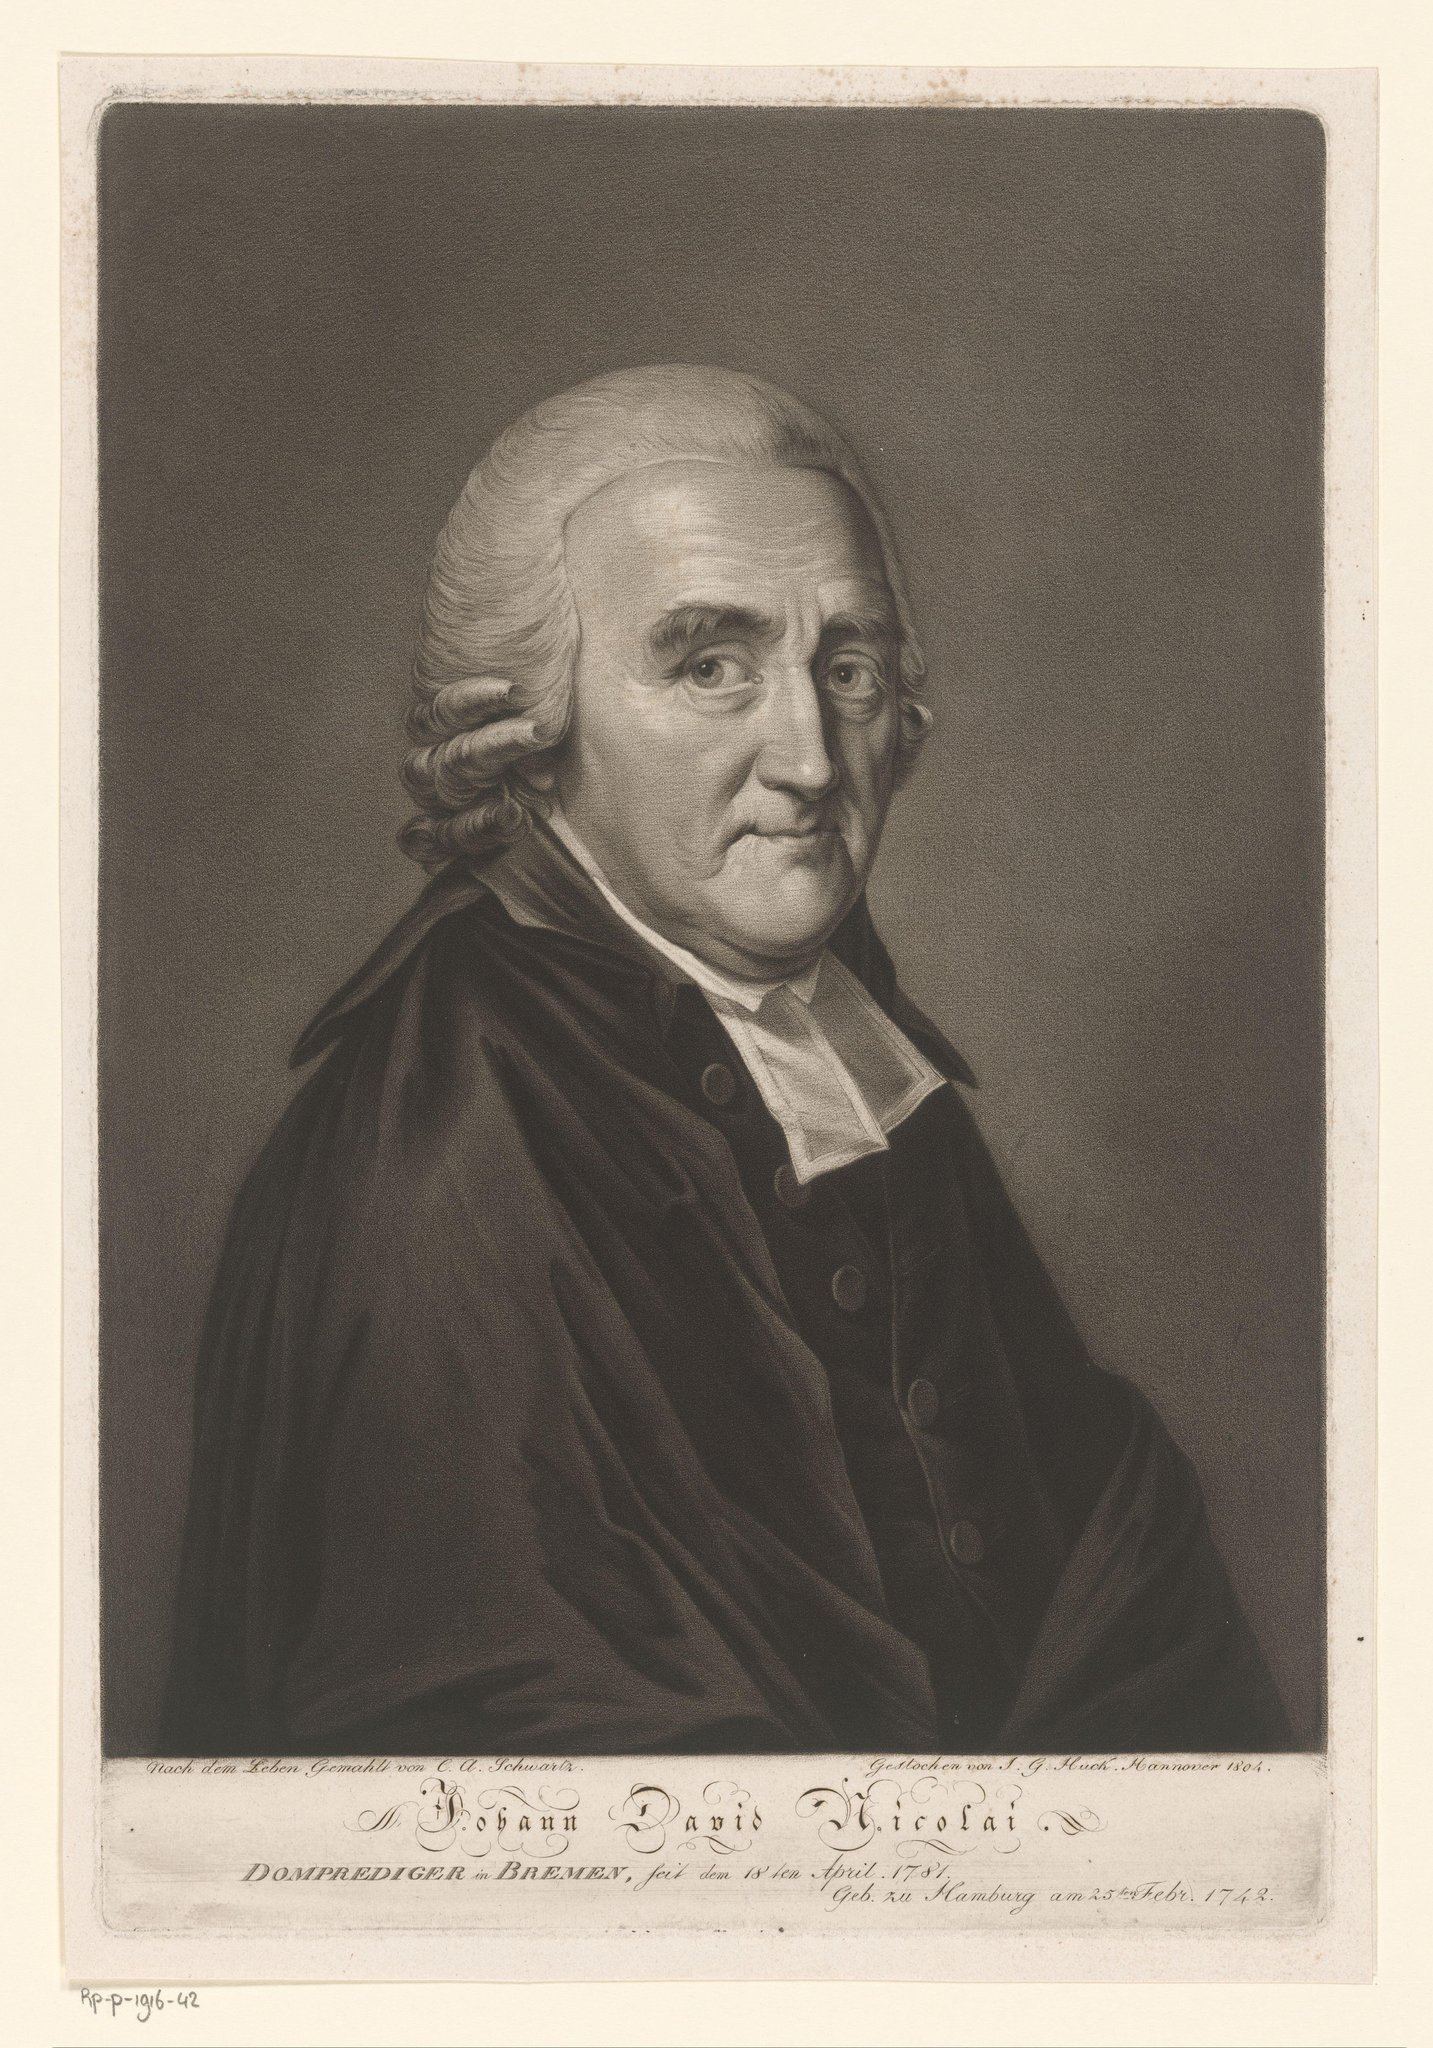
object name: print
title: Portret van Johann David Nicolai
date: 1804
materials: paper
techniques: etching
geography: hannover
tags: historical persons, functionaries and dignitaries ~ protestant churches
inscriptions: collector's mark: Lugt 2228, collector's mark: Lugt 2710